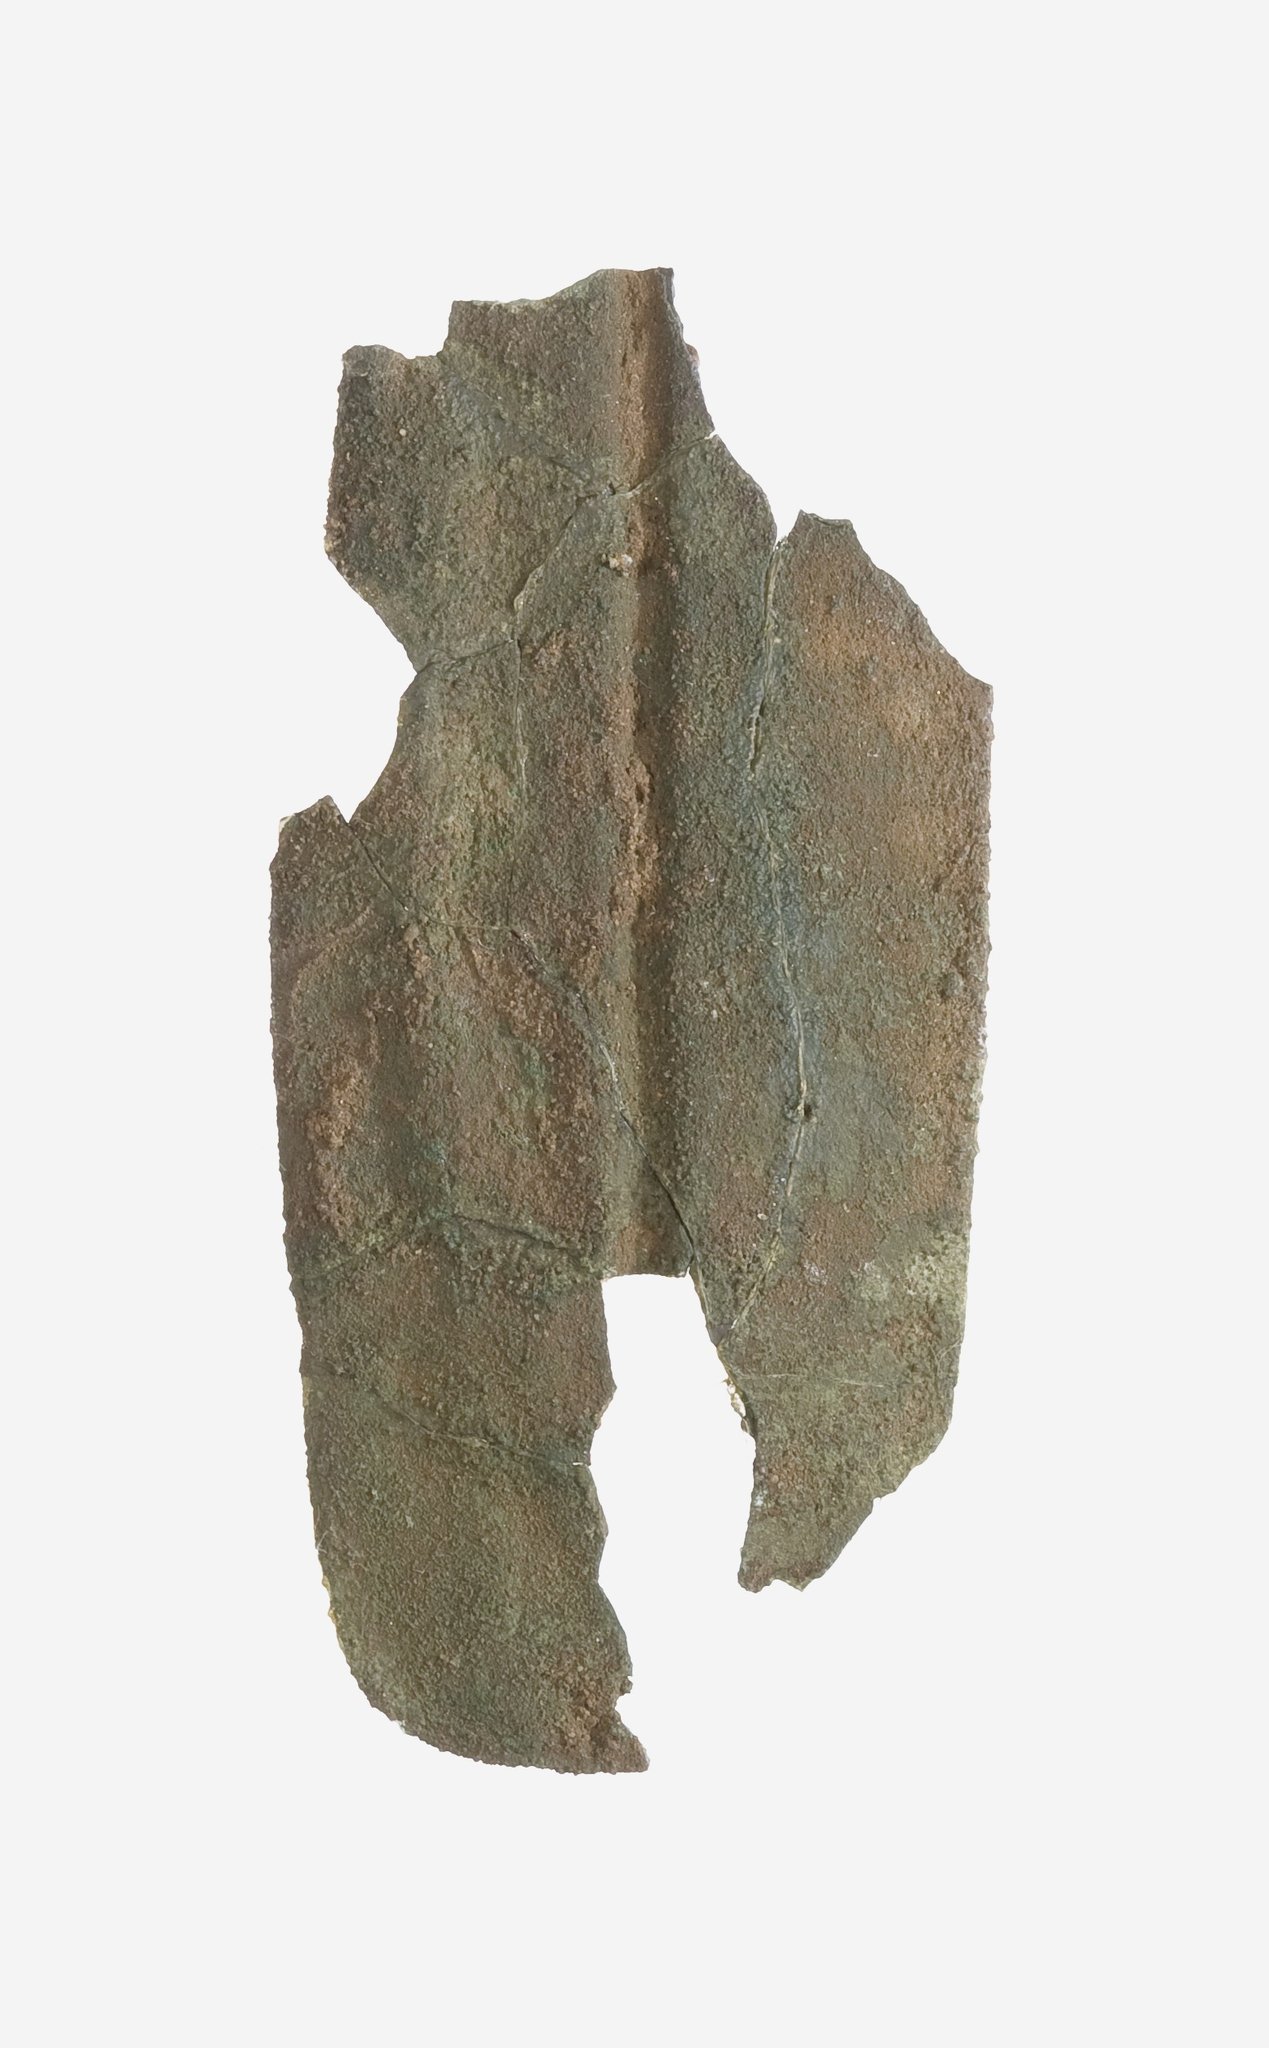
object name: armor scale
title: Scale from Armor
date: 1390-1352 BCE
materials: bronze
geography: egypt